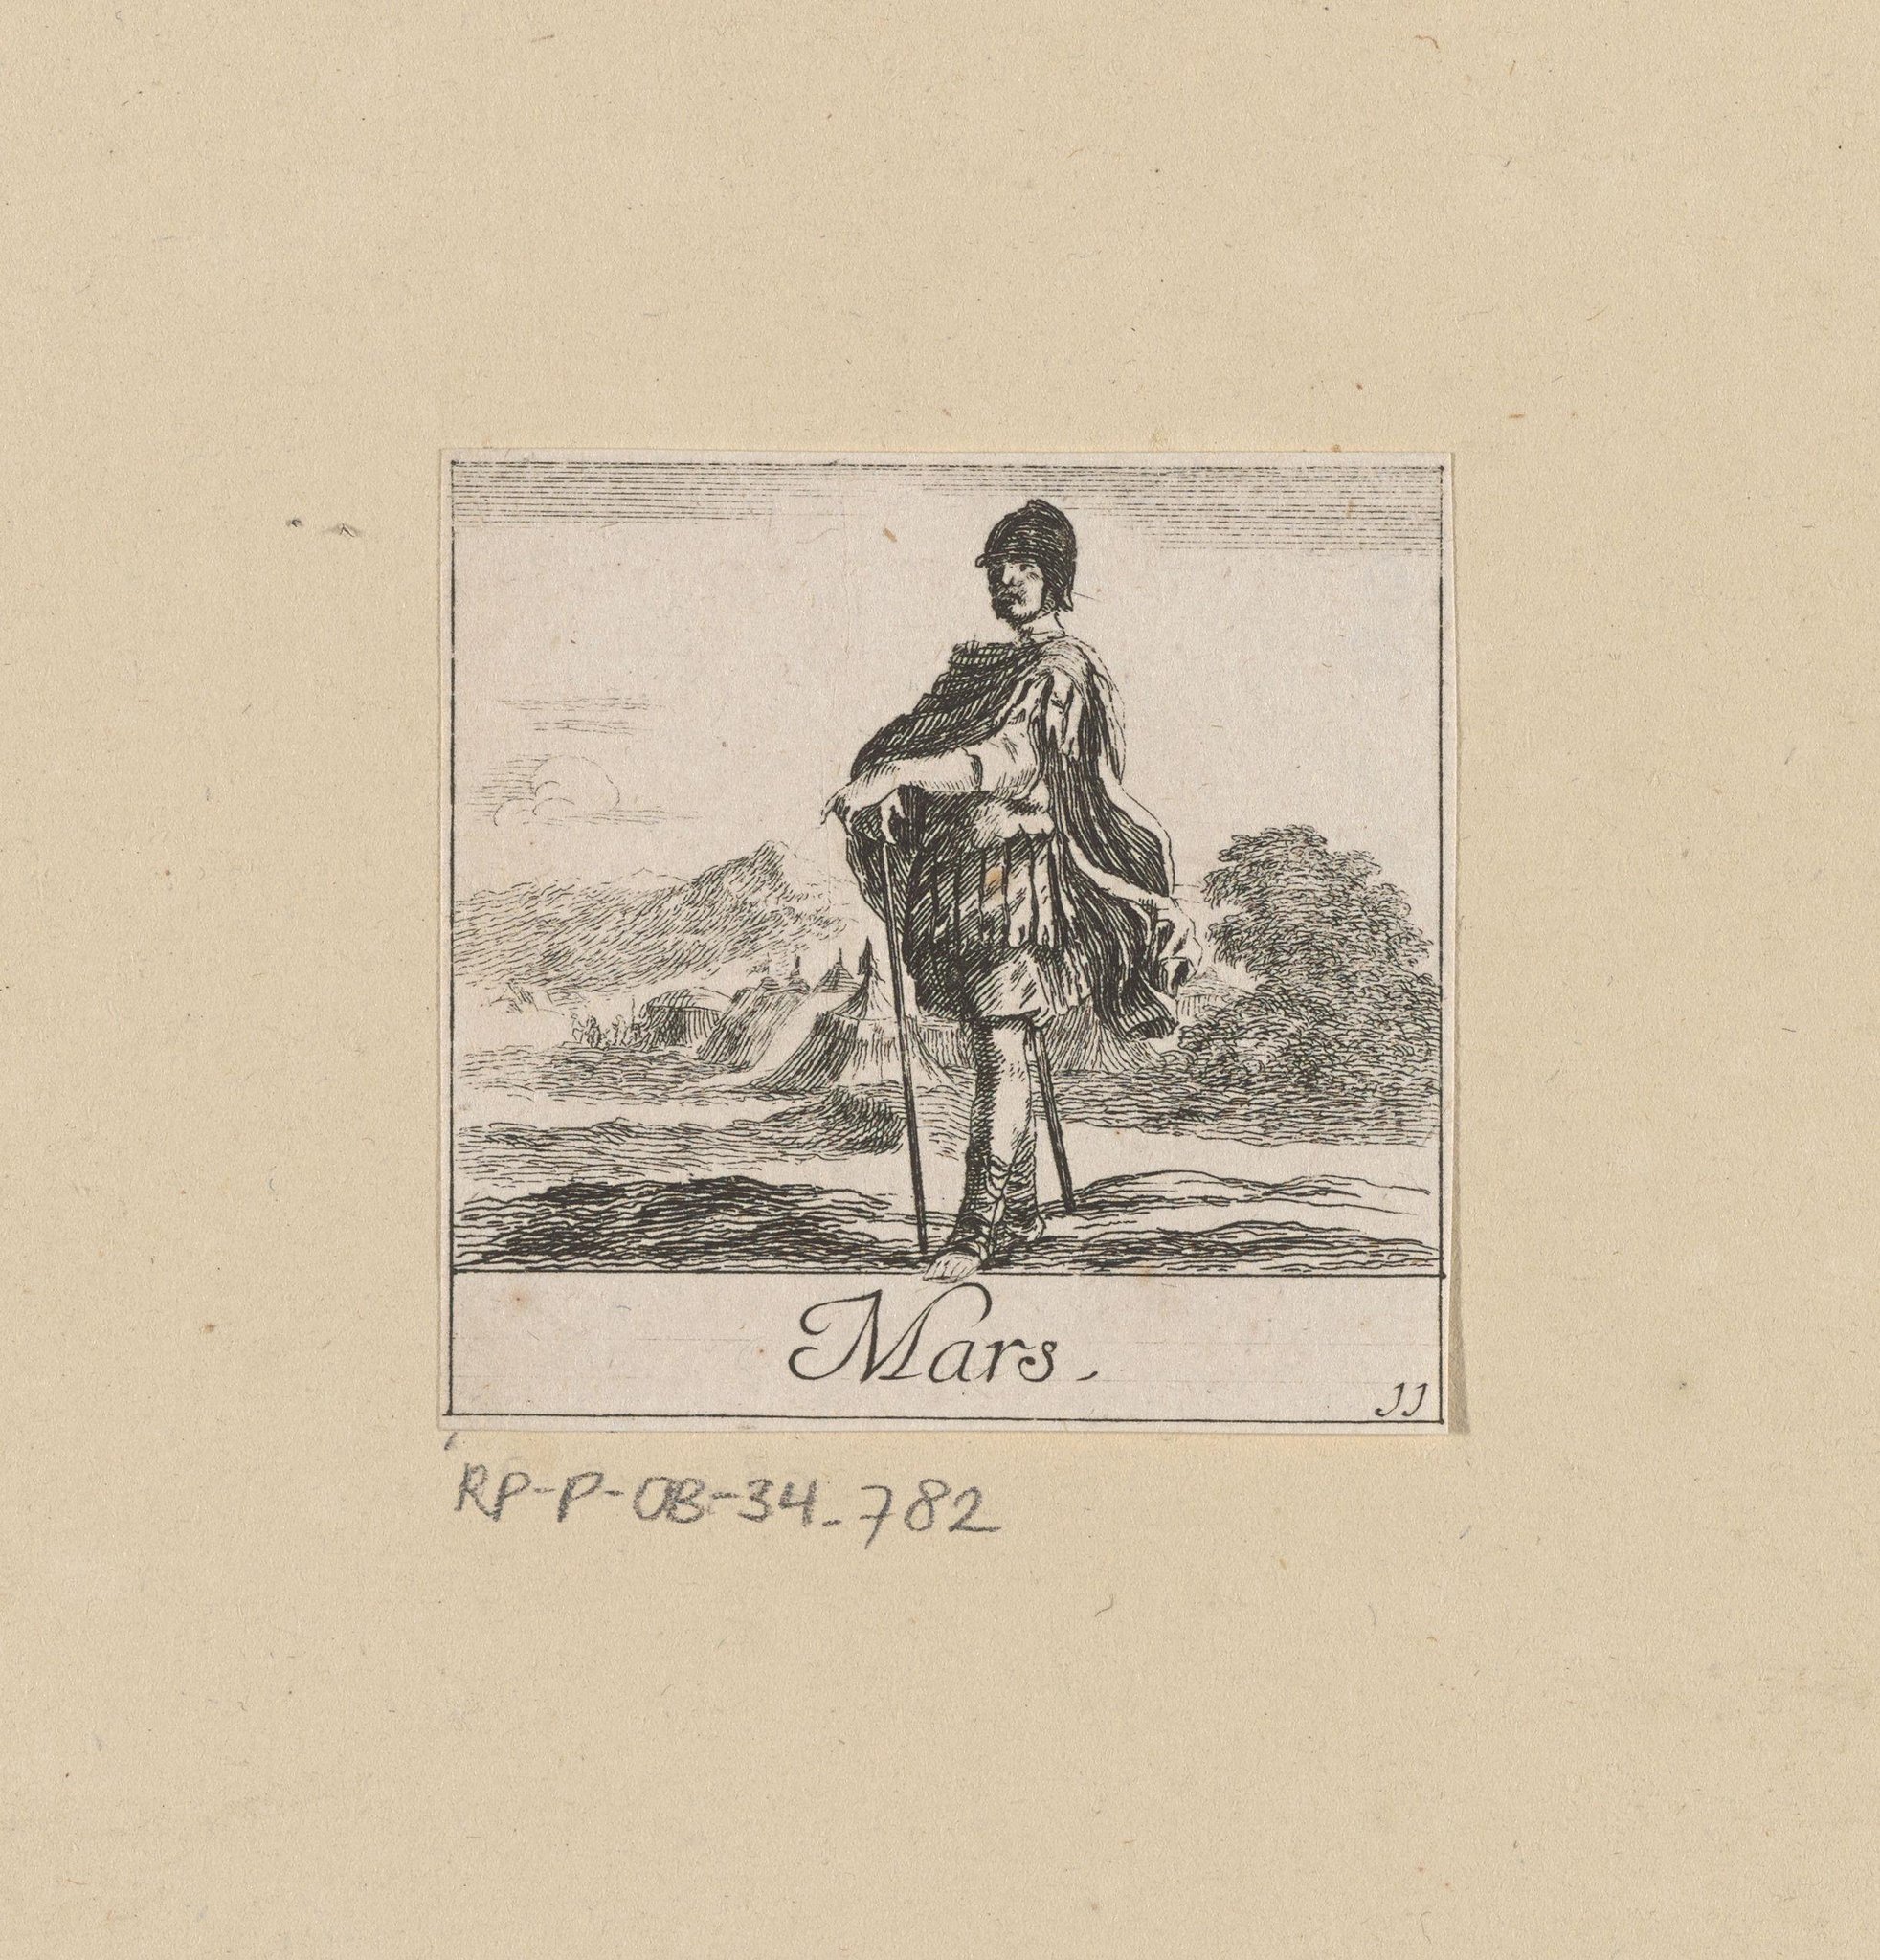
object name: playing card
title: Mars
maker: Anonymous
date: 1620-1664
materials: paper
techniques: etching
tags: (story of) mars (ares)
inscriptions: collector's mark: Lugt 240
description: Prent uit een reeks van 54 genummerde speelkaarten met voorstellingen uit de Metamorfosen van Ovidius.